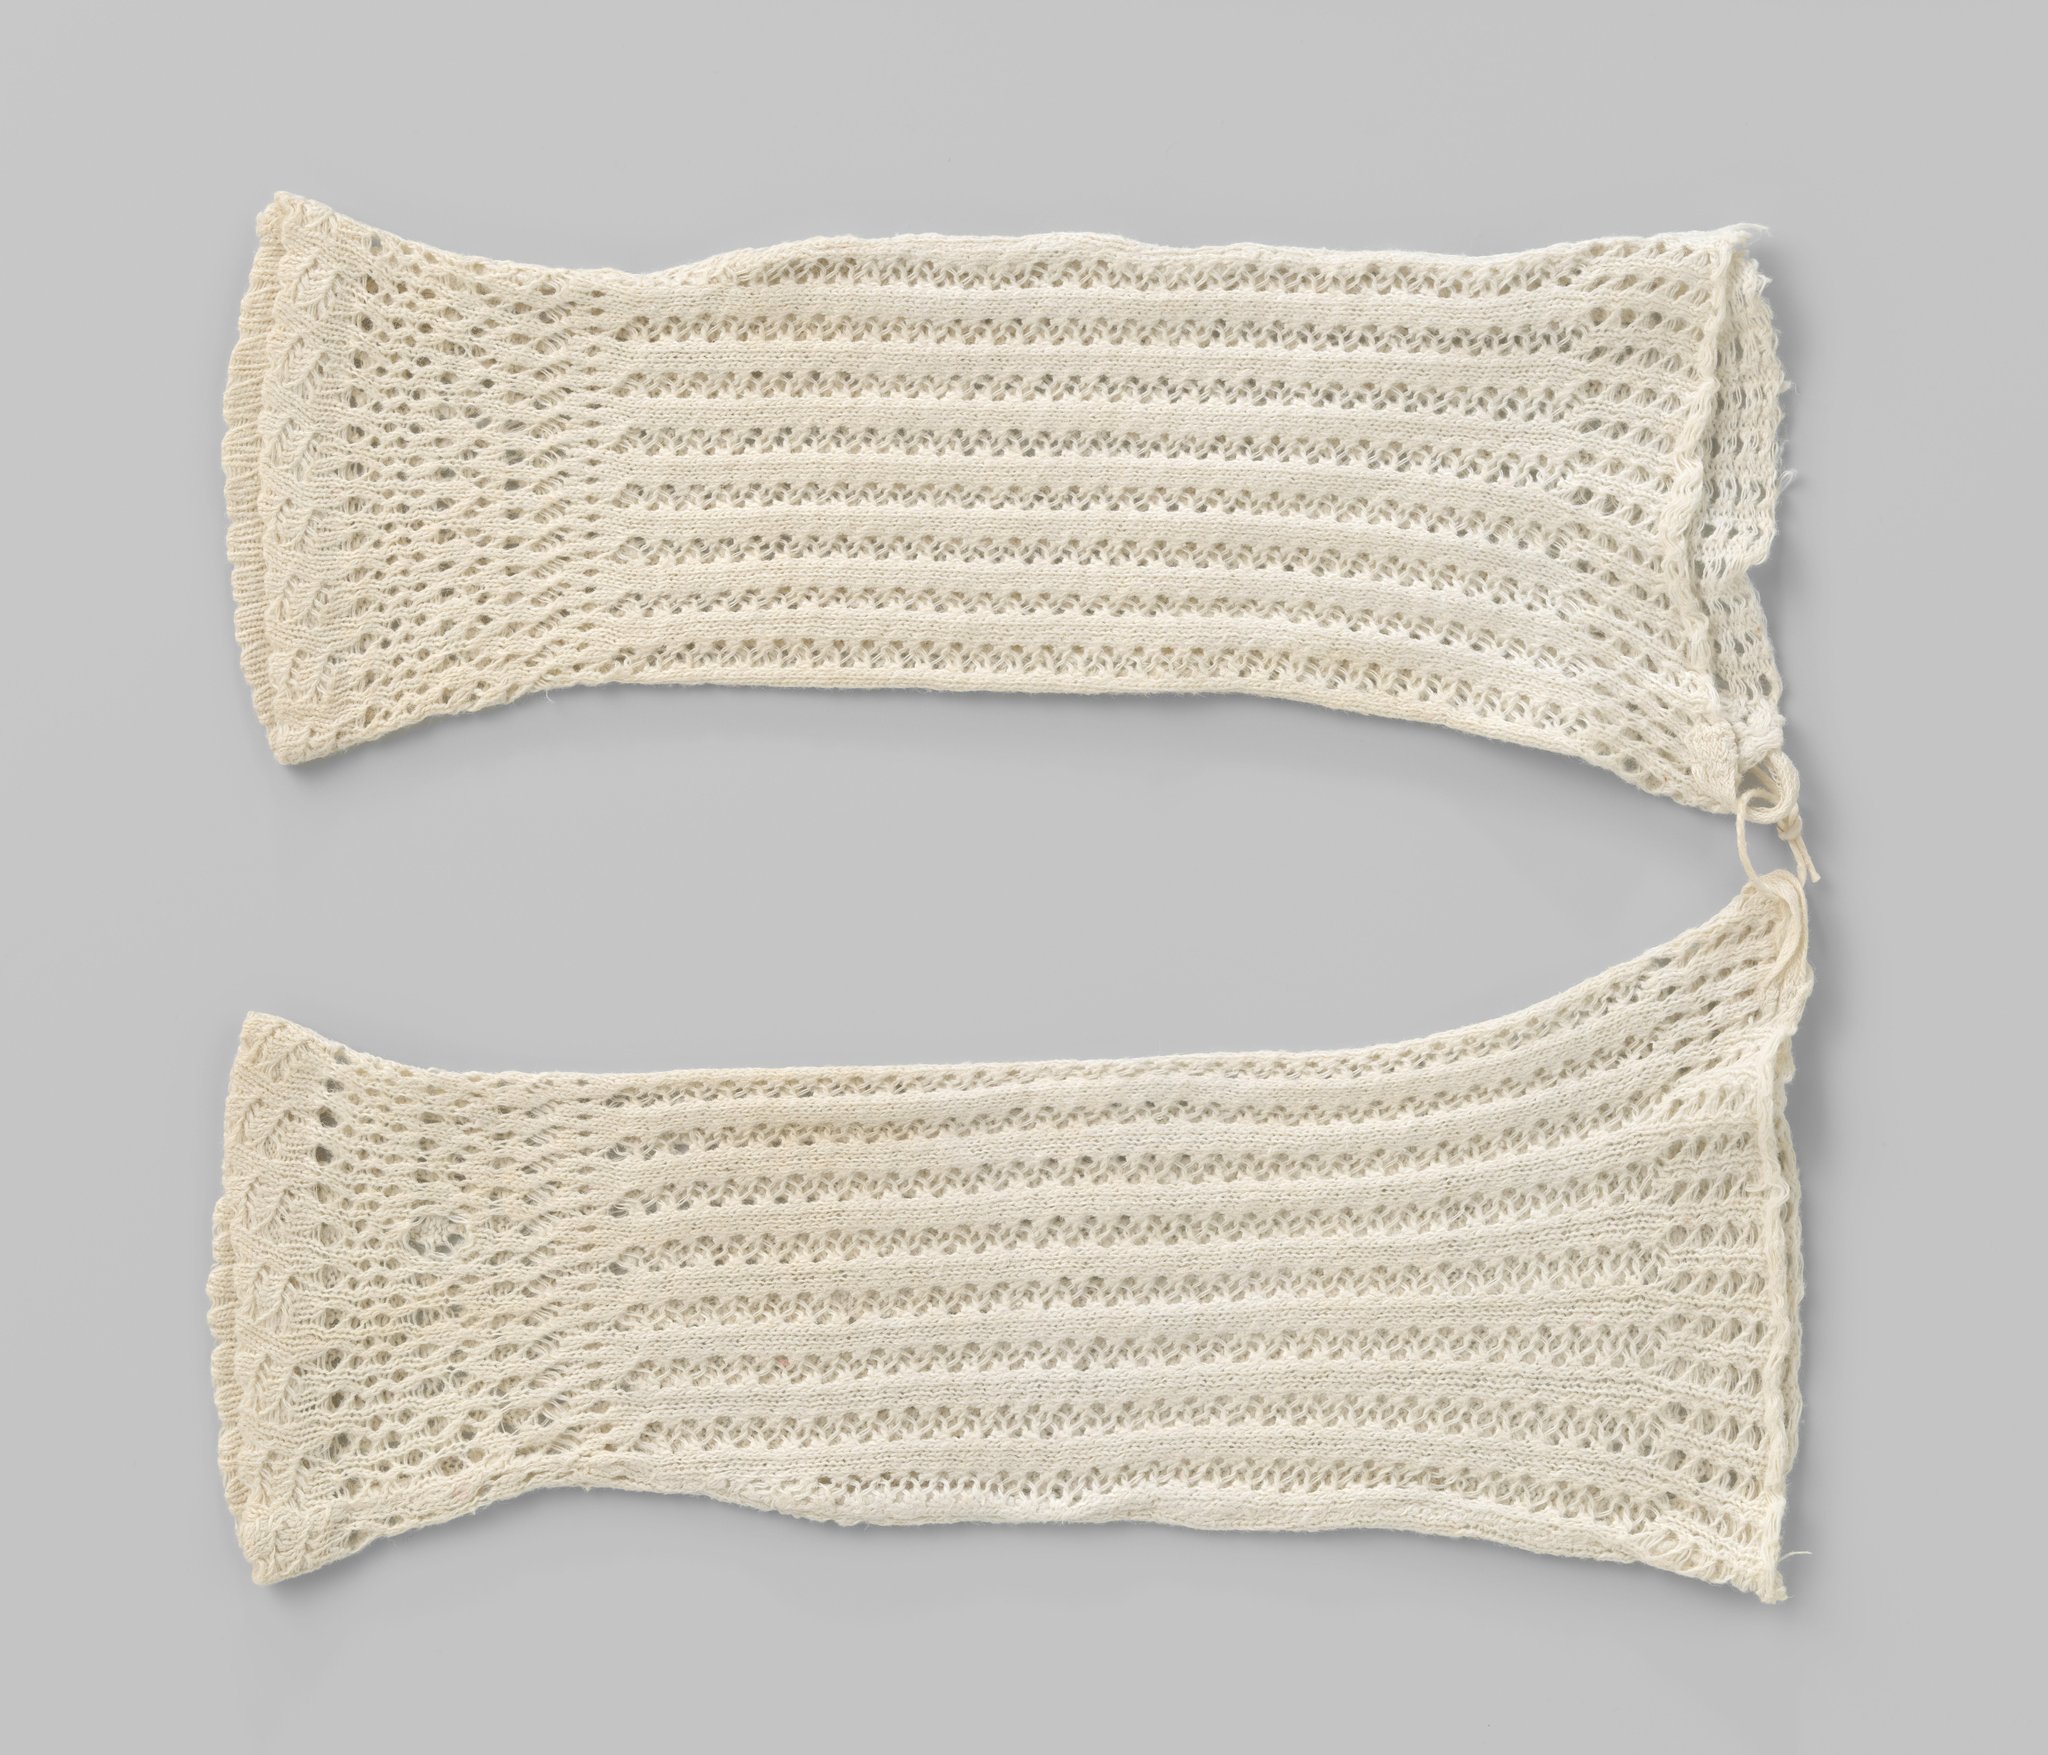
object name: sleeve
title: Wit gebreide kindermouw met ajourwerk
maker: Anonymous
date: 1800-1899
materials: textile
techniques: embroidery, knitting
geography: netherlands